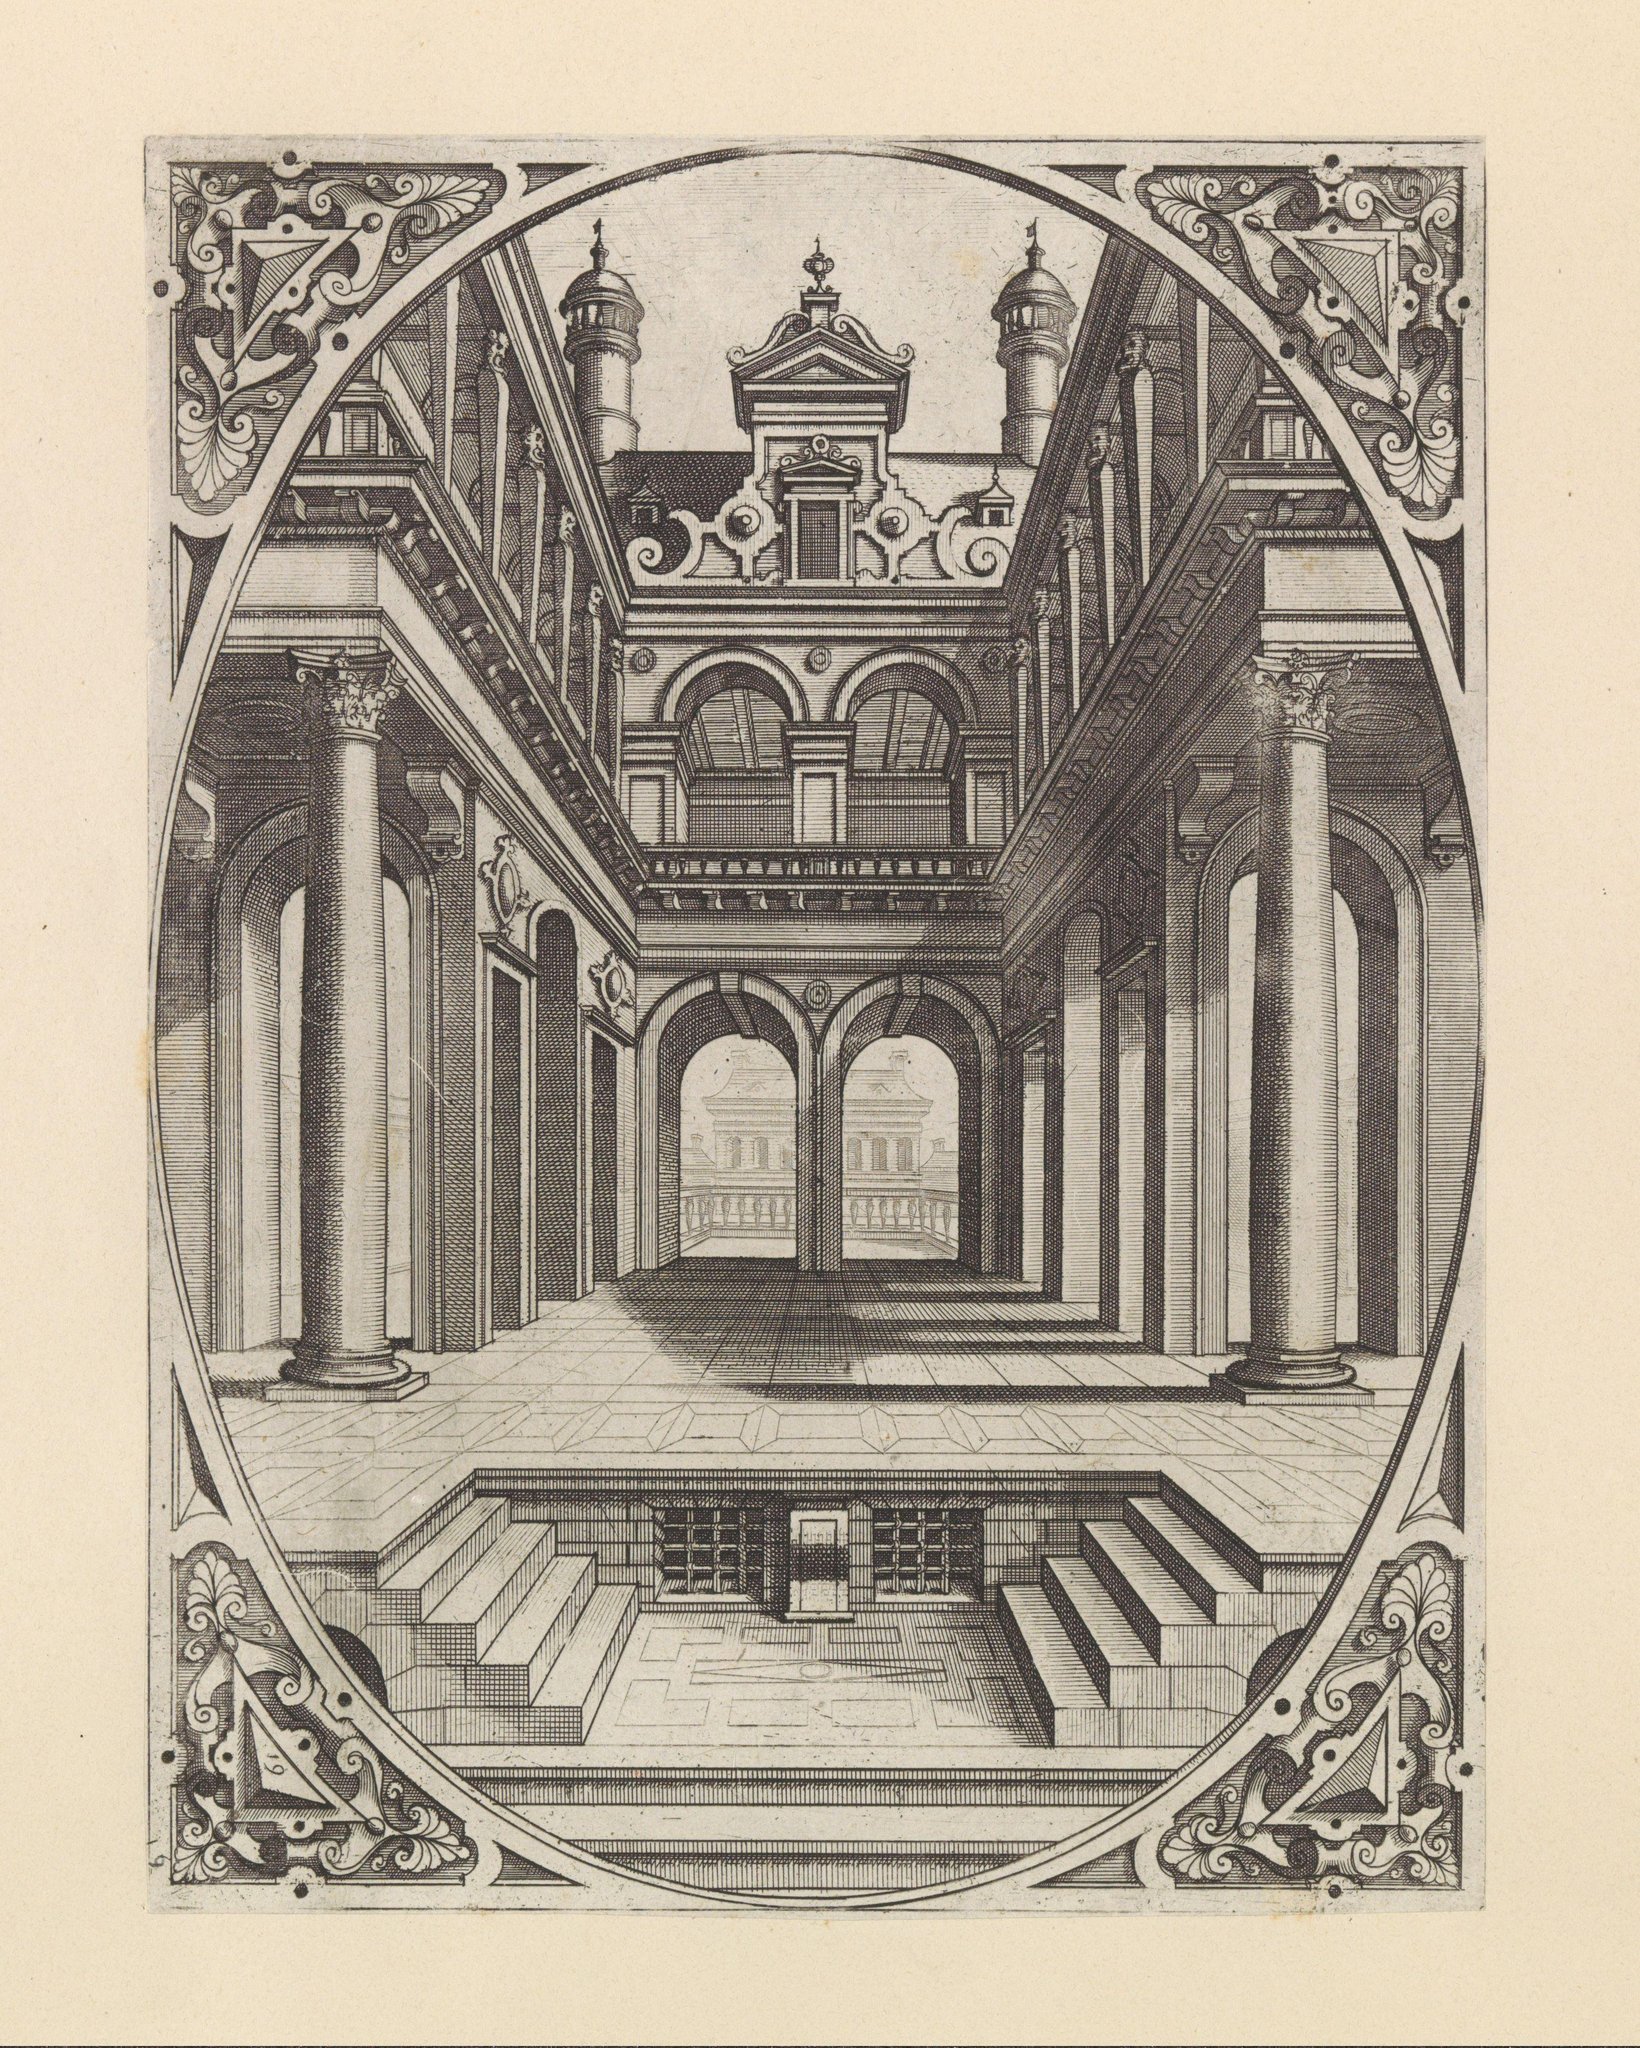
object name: print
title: Variae Architecturae Formae (...)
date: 1601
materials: paper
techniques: etching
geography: antwerp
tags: architectural representations in general, gallery (spacious corridor)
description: Gezicht op een binnenplaats met een galerij met bovenverdieping. Langs de bovenste galerij hermen. In de hoeken diamantvormen op rolwerk met palmetten. De prent maakt deel uit van een album.